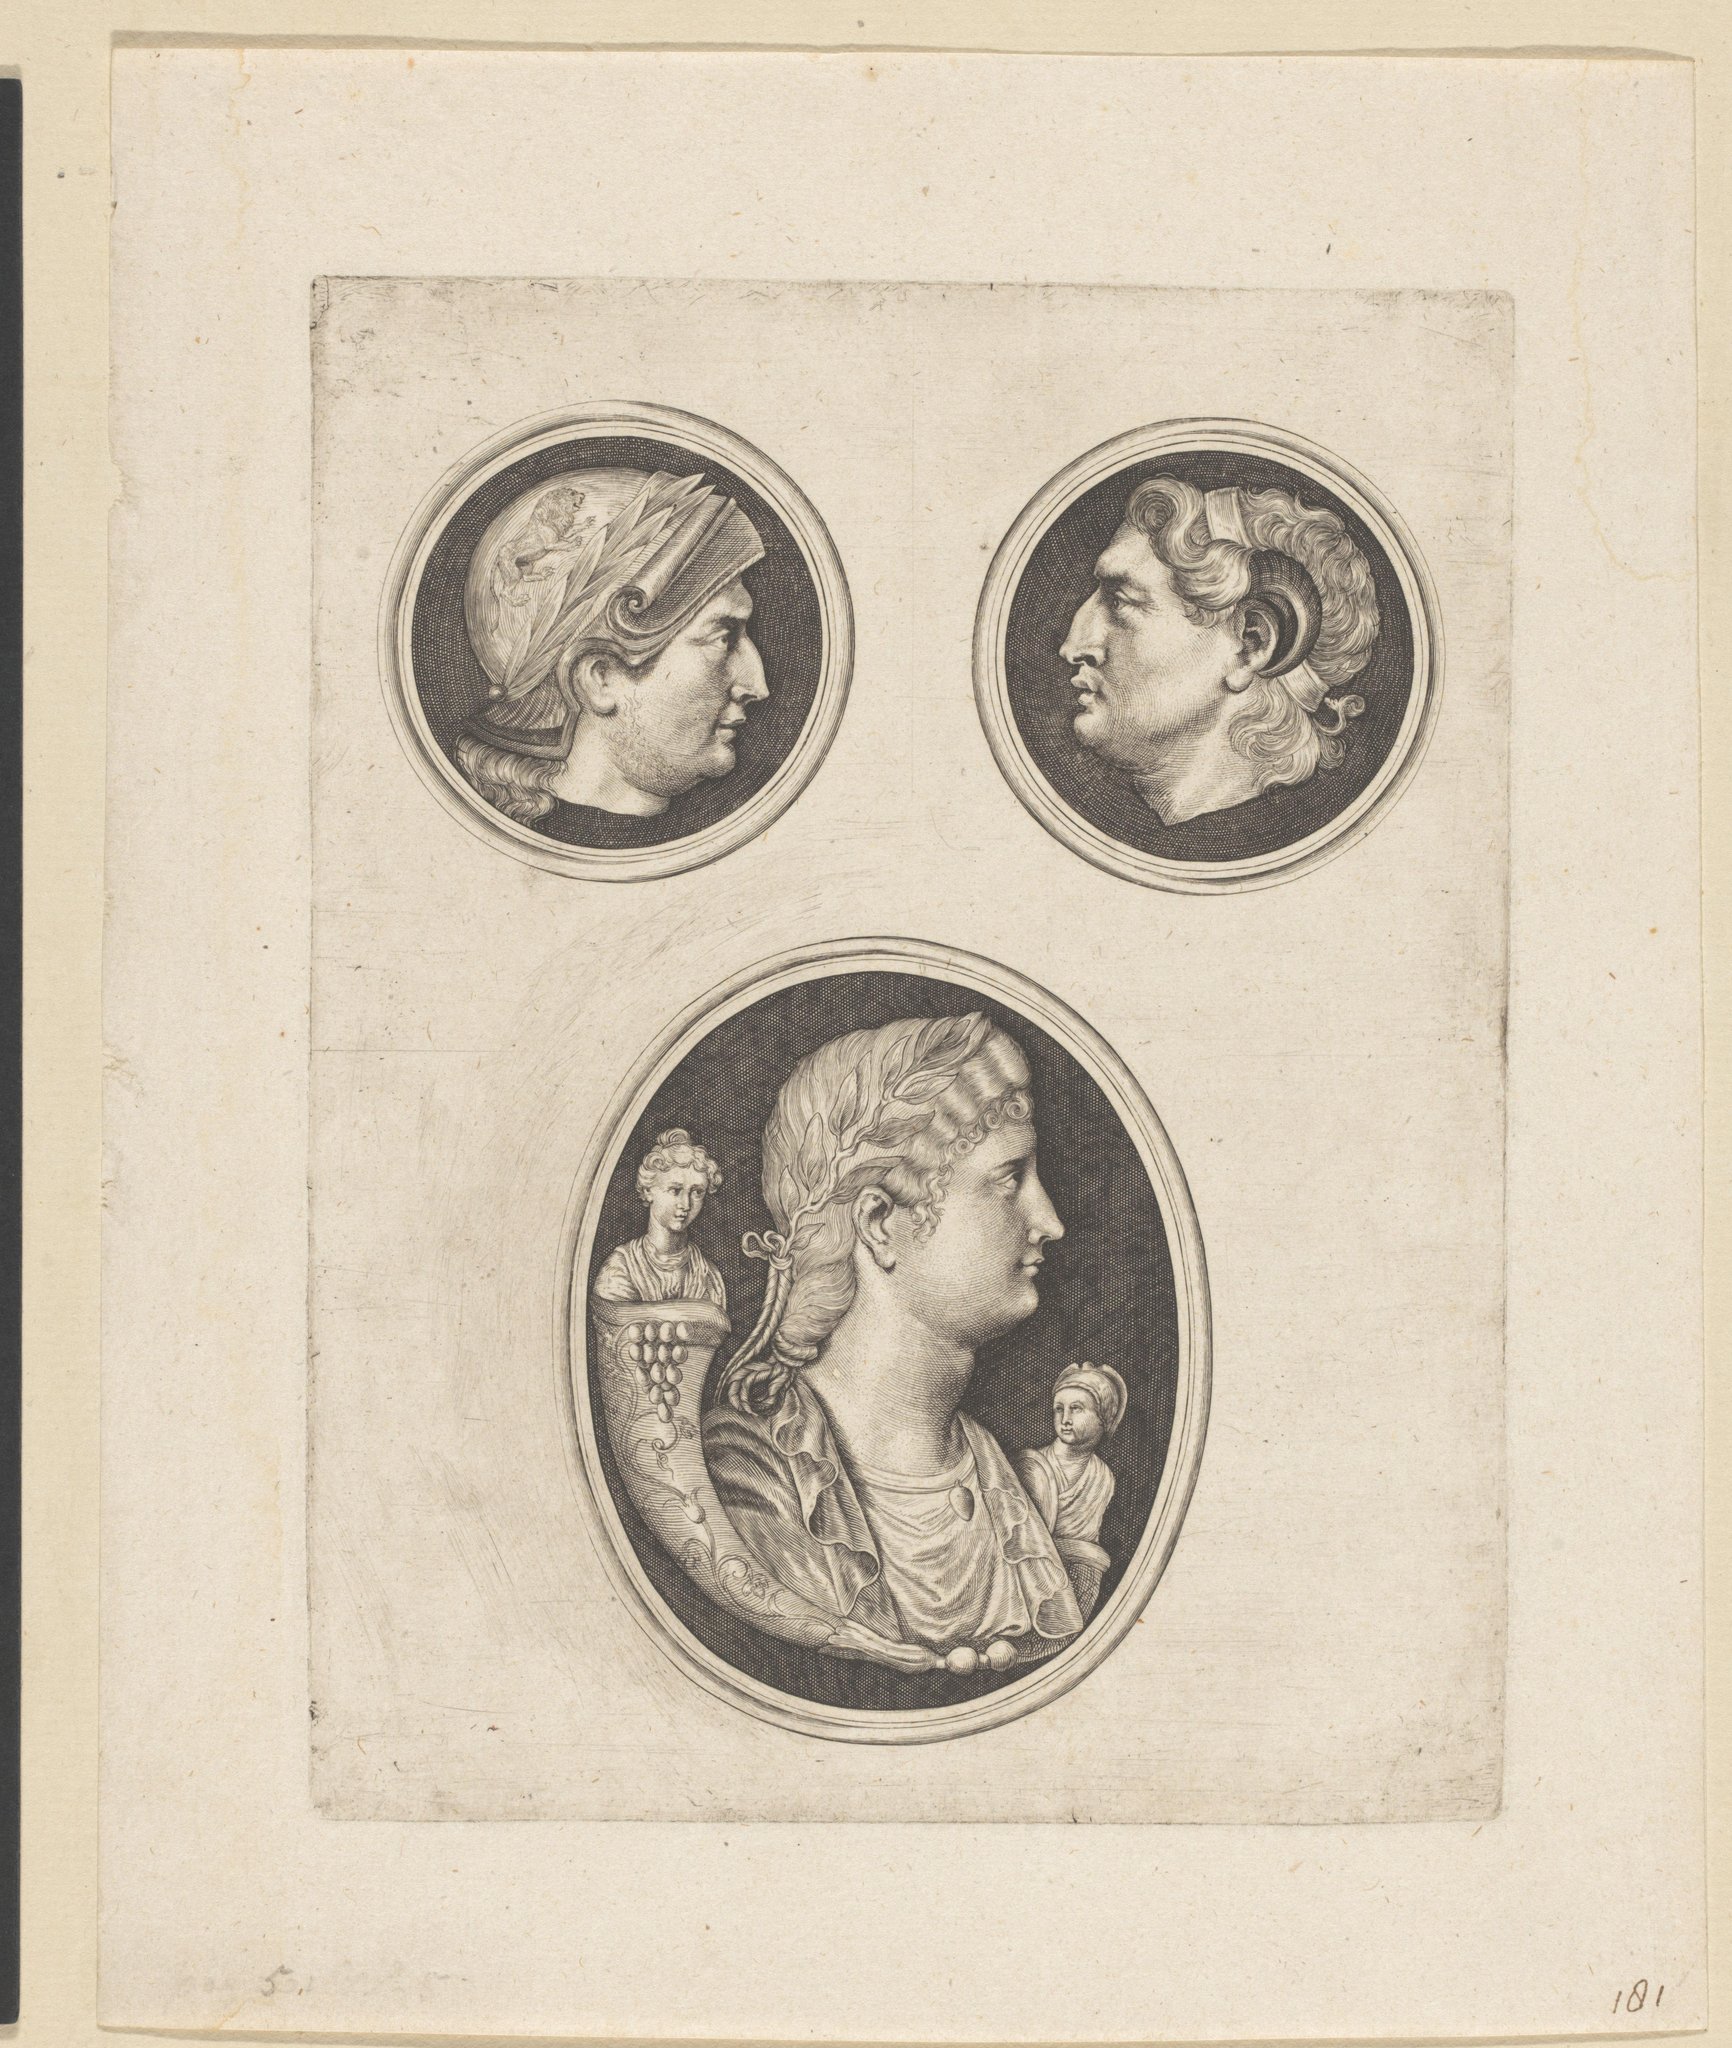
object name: print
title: Drie klassieke bustes in profiel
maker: lucas vorsterman (i)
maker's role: print maker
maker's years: 1595-1675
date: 1622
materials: paper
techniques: engraving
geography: antwerp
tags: pella, babylon, koning, veldheer, alexander de grote, keizerin, messalina statilia (romeins keizerin)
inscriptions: collector's mark: Lugt 240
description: Drie antieke bustes in profiel: linksboven Alexander de Grote als Hercules, rechtsboven Hercules als Jupiter Ammon en onder de Romeinse keizierin Messalina Statilia. Prent uit de serie 'Varie Figueri de Agati Antique' naar Peter Paul Rubens, van in totaal negen prenten waarvan vermoedelijk vijf door Lucas Vorsterman I en vier door Paulus Pontius.